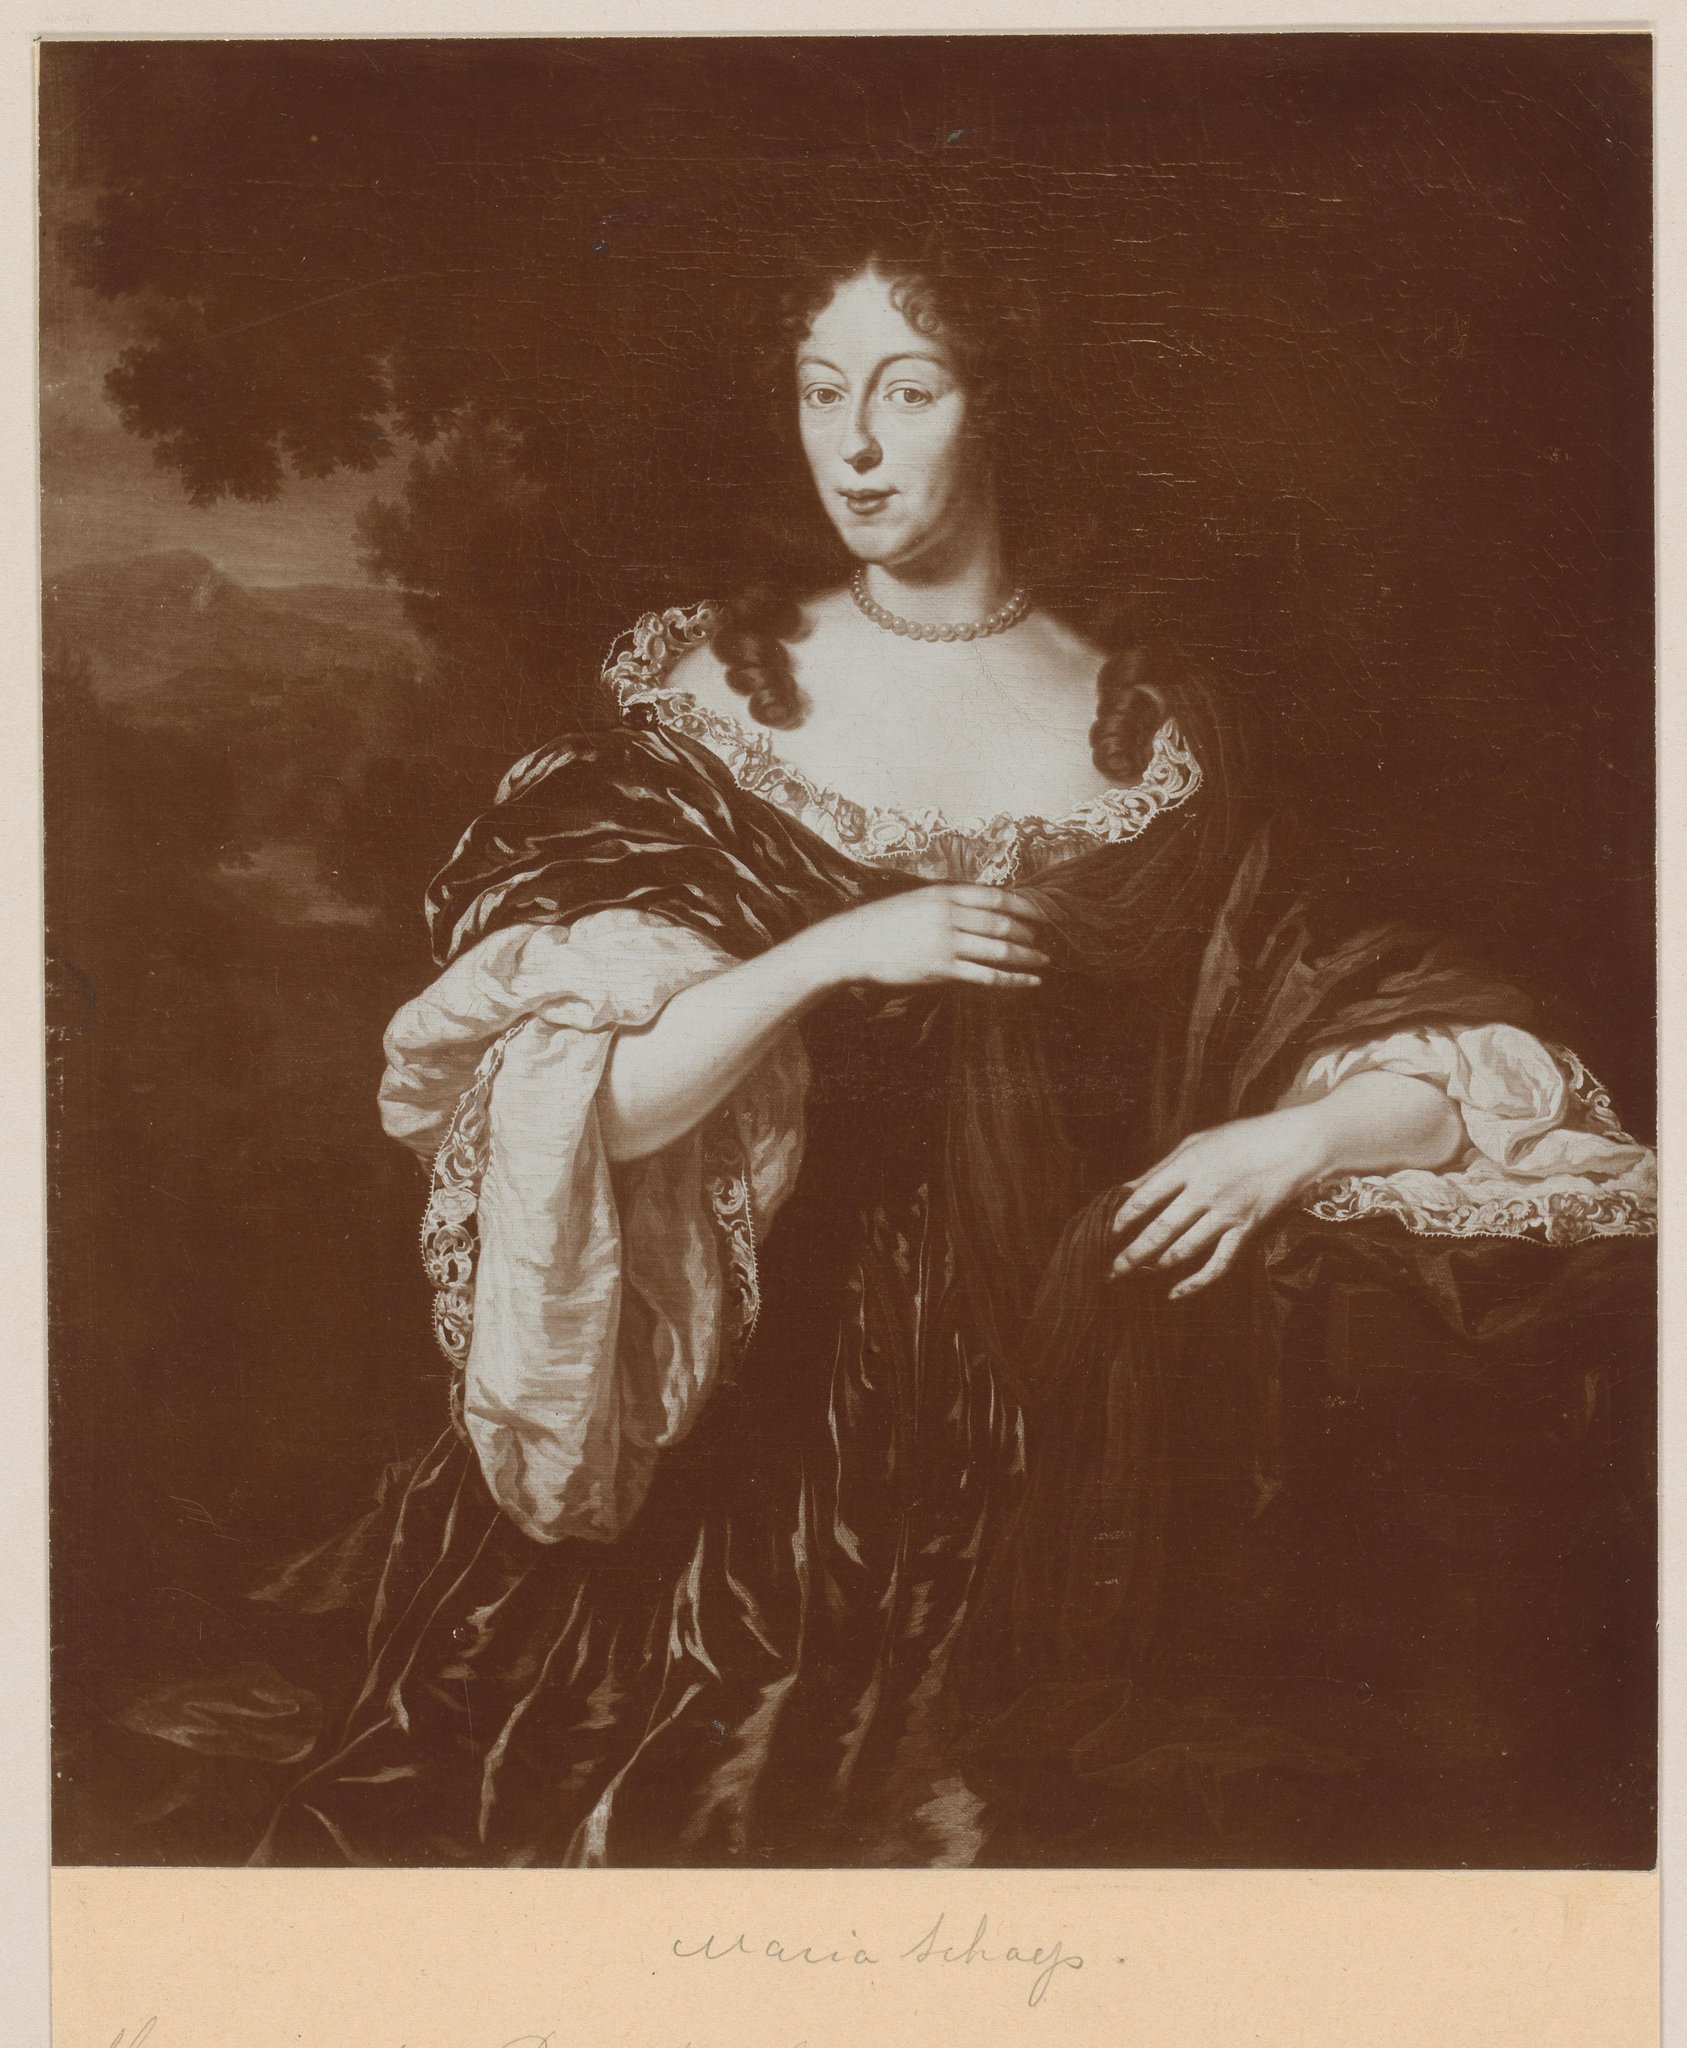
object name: reproduction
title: Fotoreproductie van een geschilderd portret van Maria Schaep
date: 1880-1910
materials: paper, cardboard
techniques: collodion silver print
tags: historical persons - bb - woman